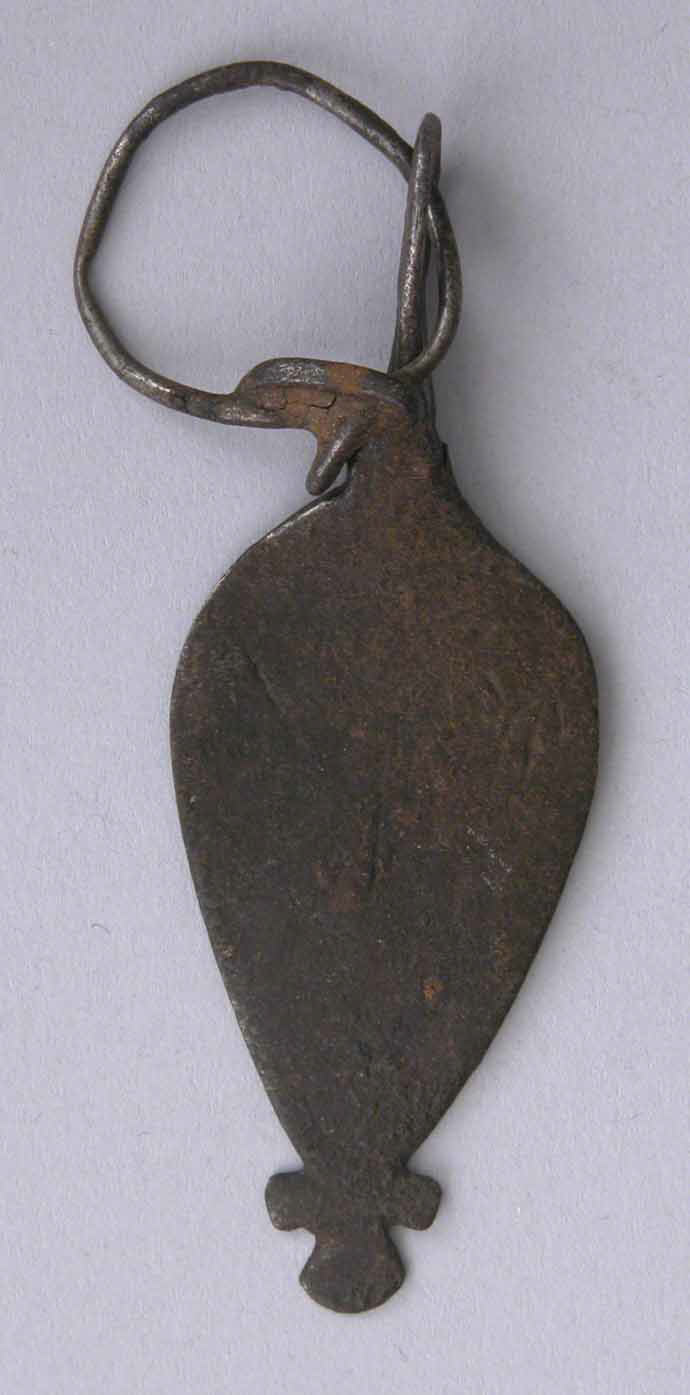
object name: earring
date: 201-1200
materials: iron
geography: egypt